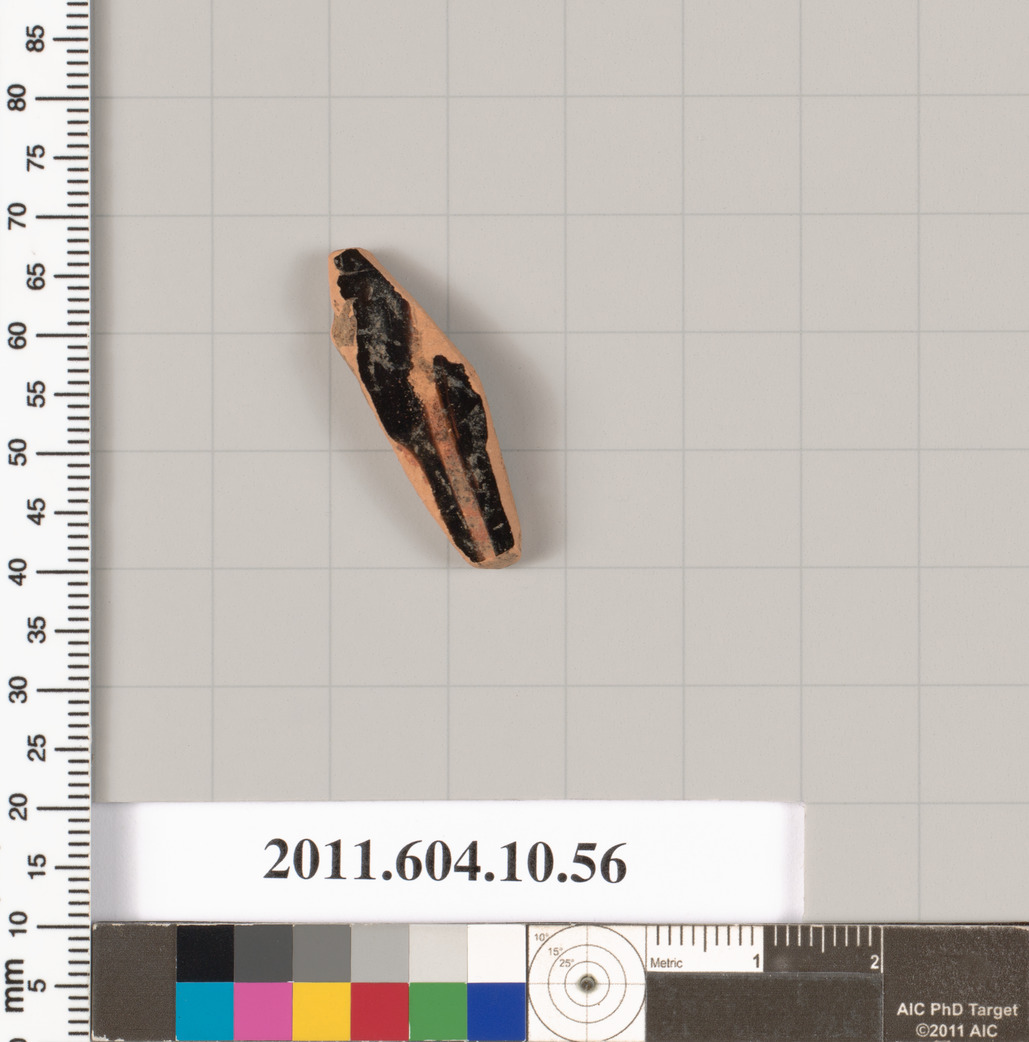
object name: kylix fragment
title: Terracotta fragment of a kylix (drinking cup)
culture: etruscan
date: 334-301 BCE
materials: terracotta